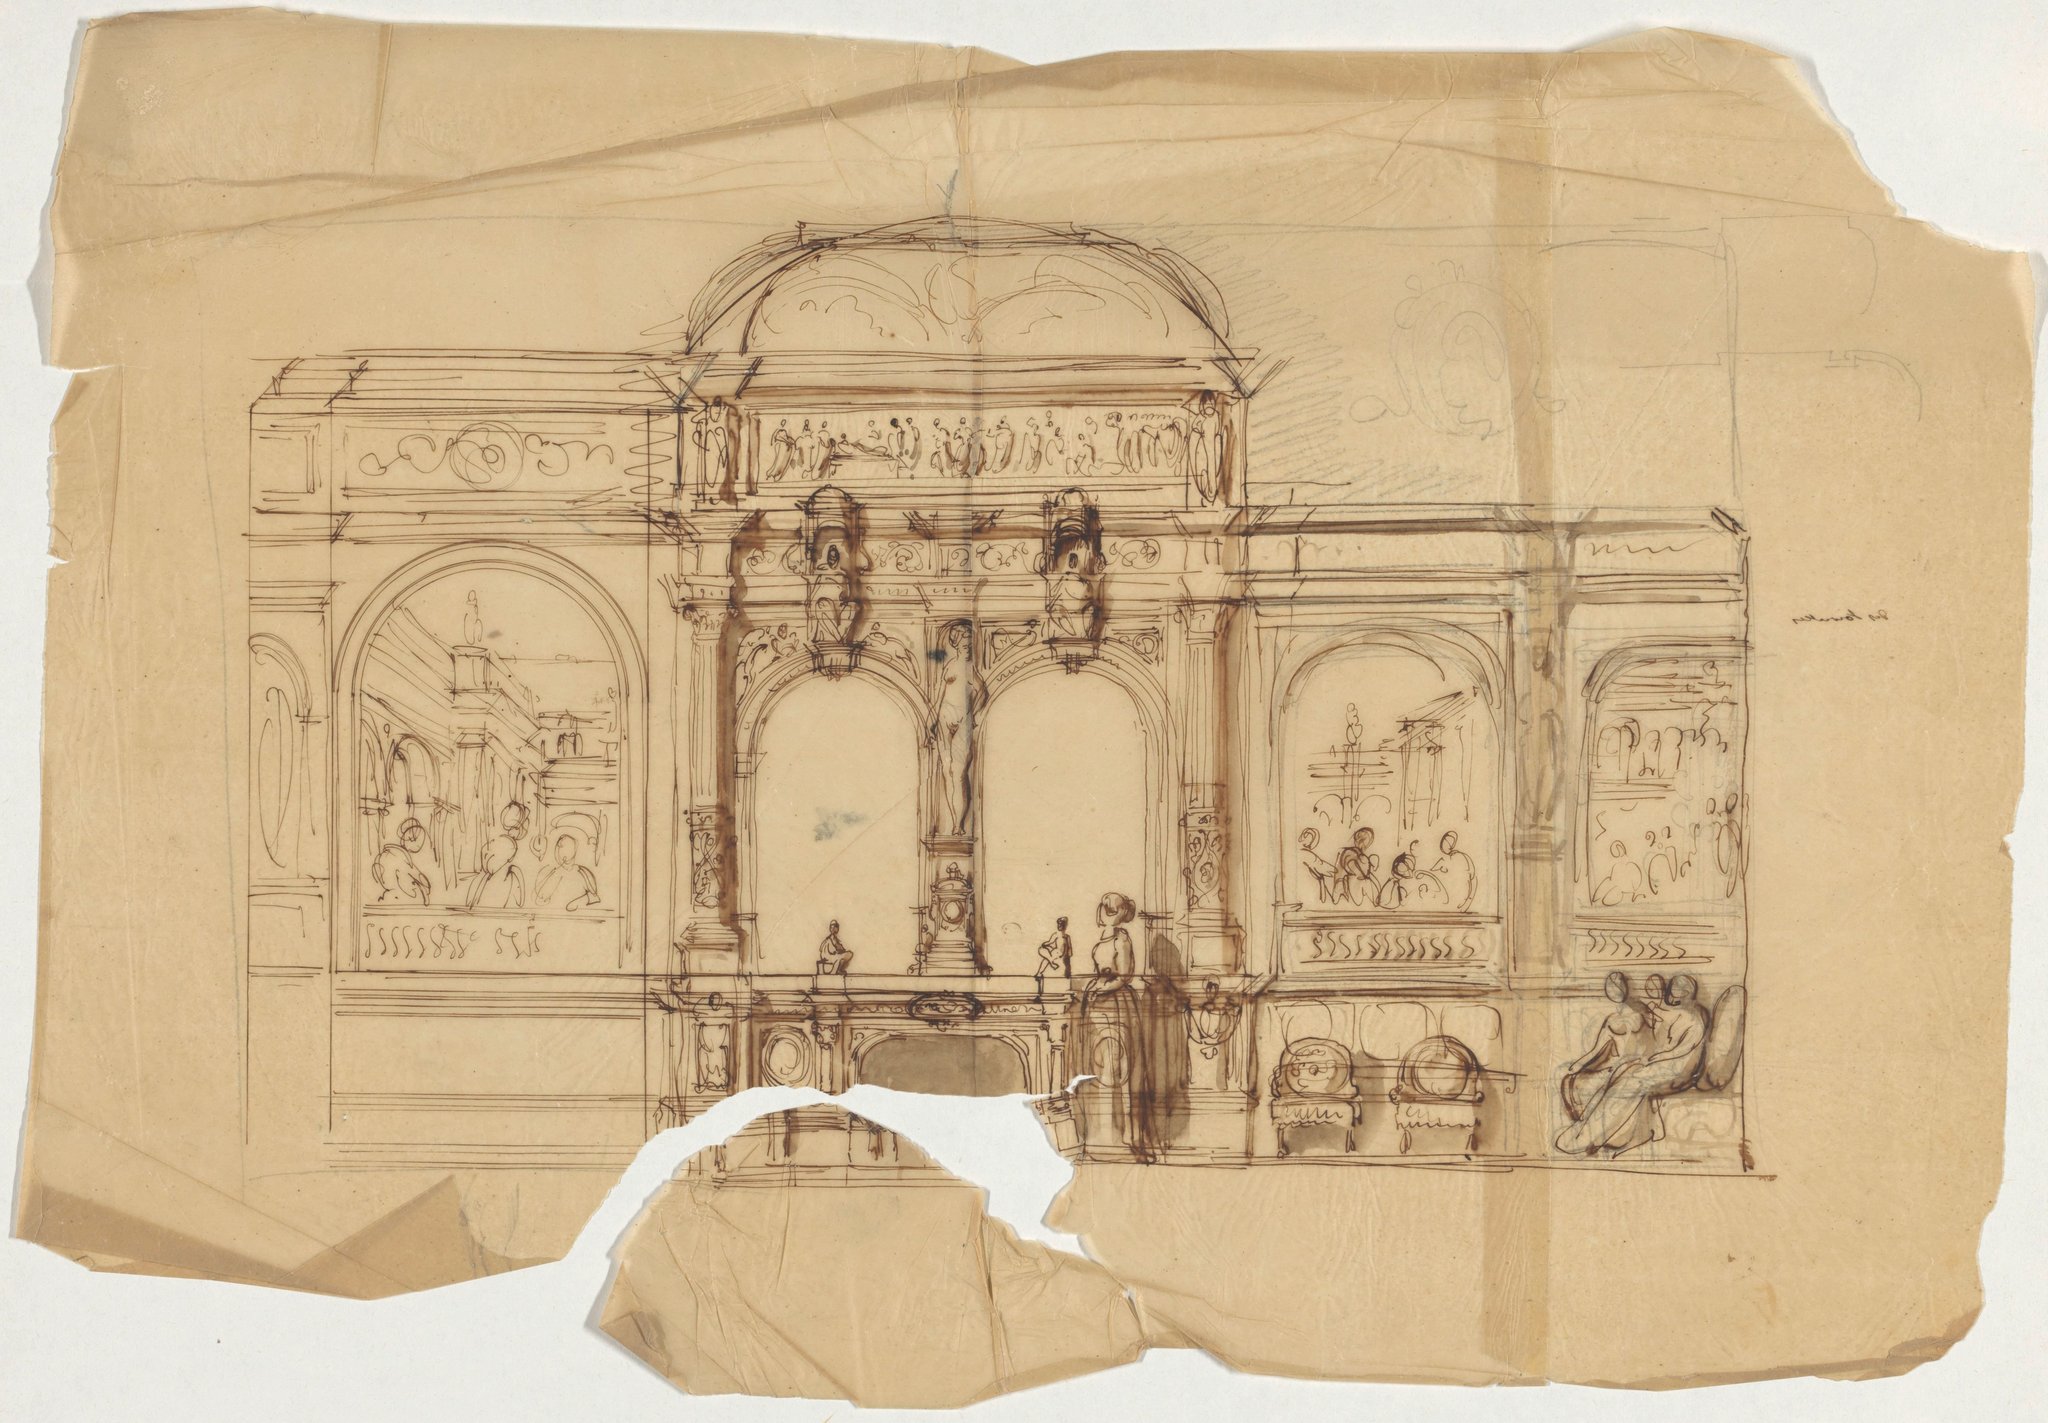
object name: design drawing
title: Façade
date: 1830-1850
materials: graphite, paper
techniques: brush, pen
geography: paris